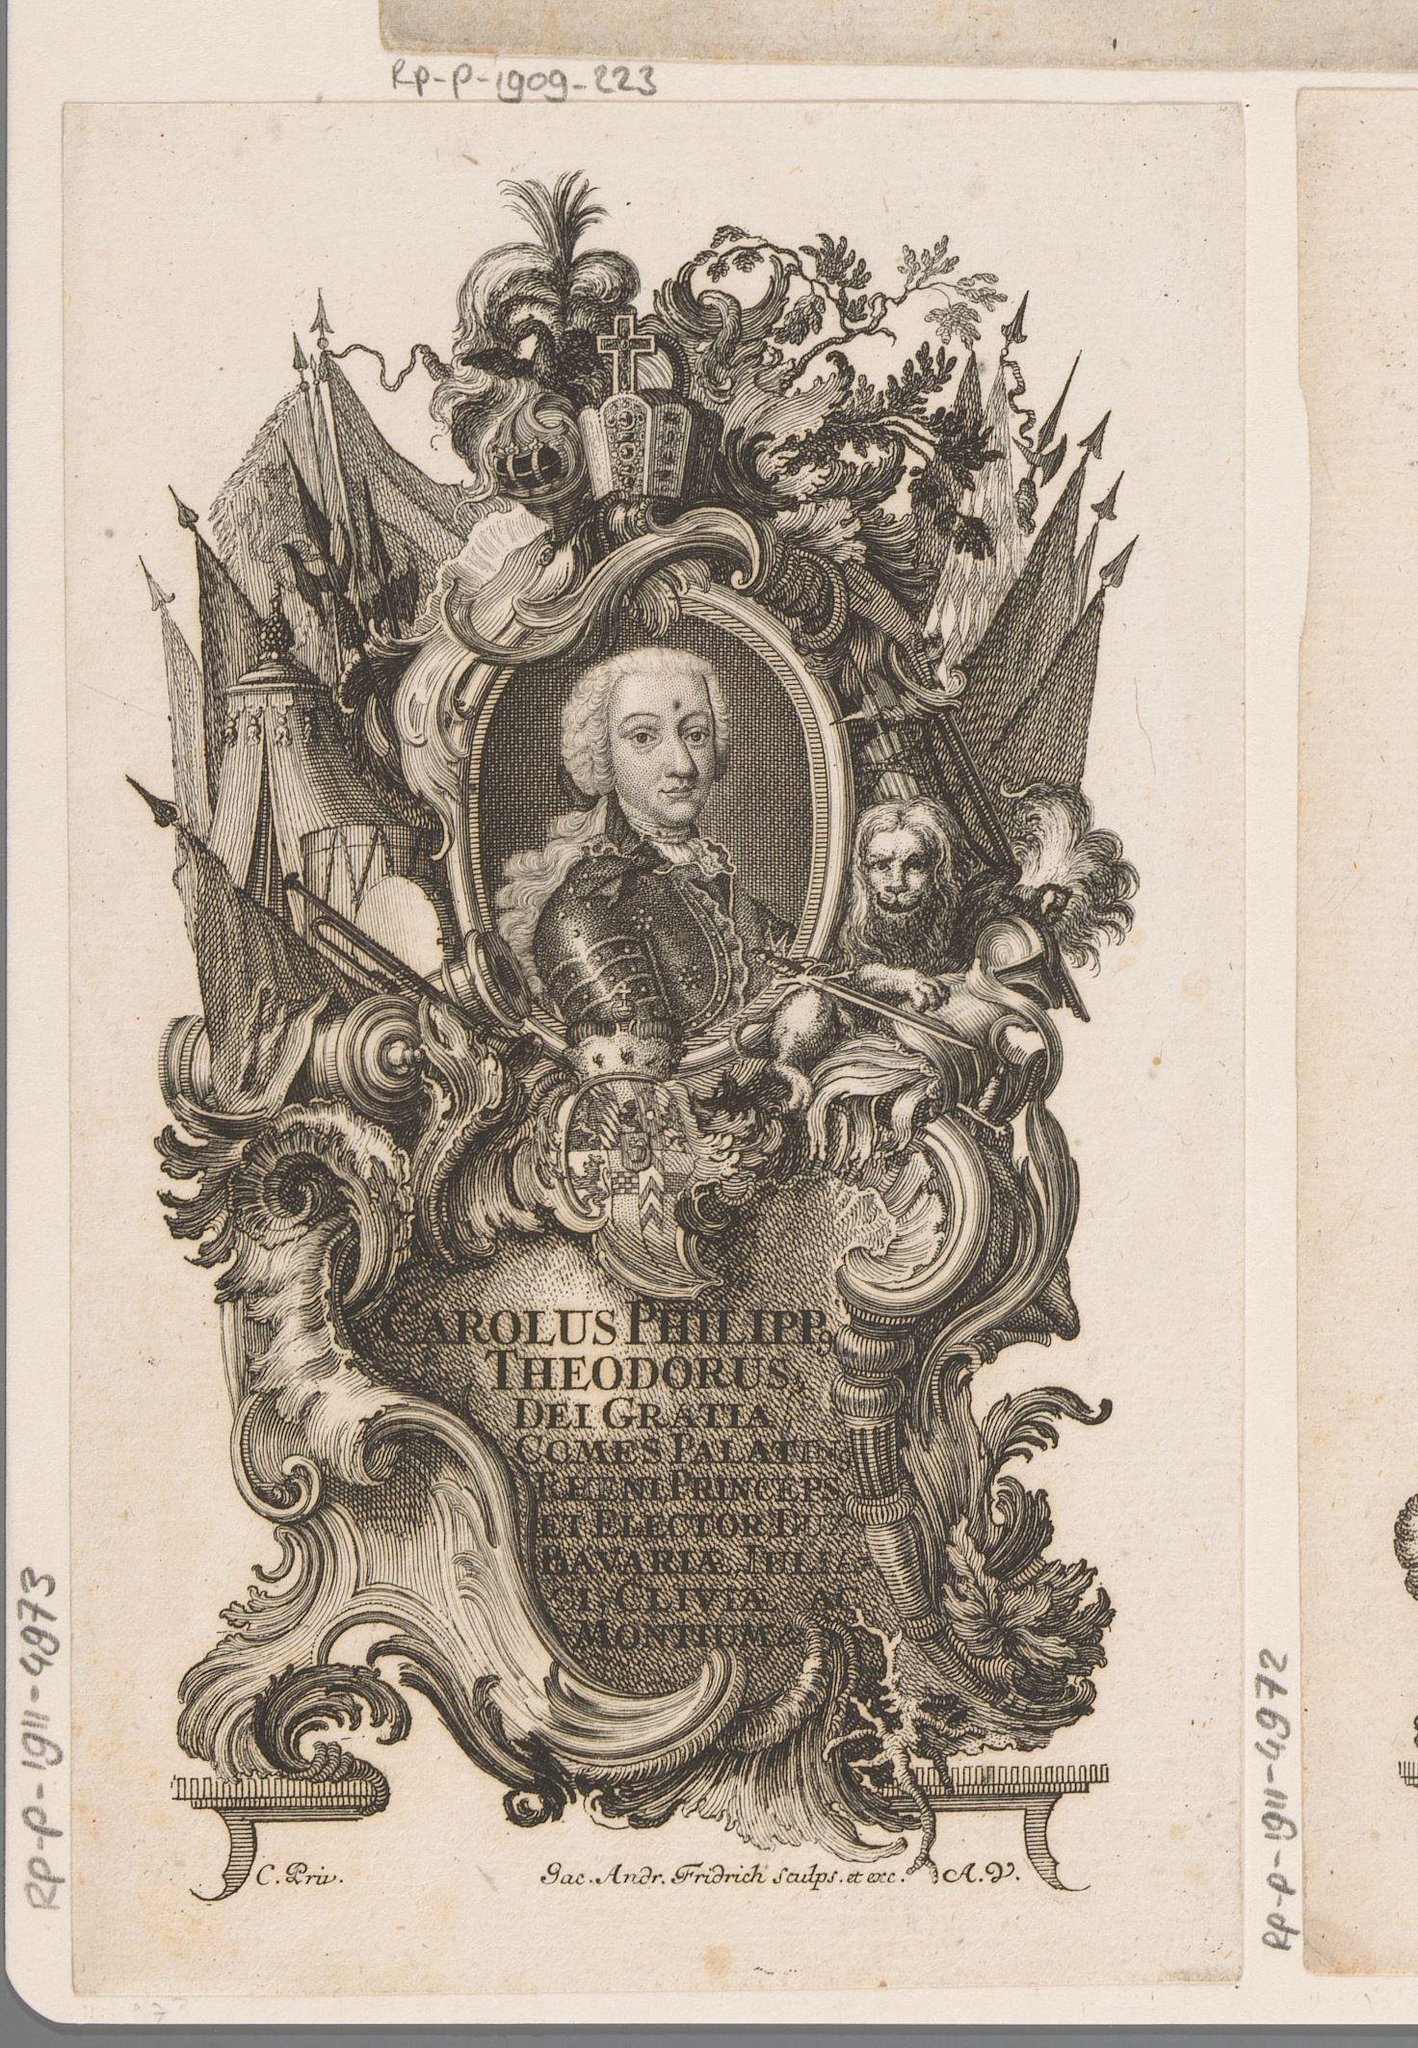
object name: print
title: Portret van Karel Theodoor van Beieren in allegorische omlijsting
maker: Anonymous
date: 1734-1779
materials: paper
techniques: engraving, etching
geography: holy roman empire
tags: brussels, karel theodoor van beieren (hertog), rocaille ornament, armour, historical persons, ruler, sovereign, symbols, allegories of war; 'guerra' (ripa), insignia and symbols of sovereignty (crown, diadem, sceptre, orb, seal, standard, cloak, pectoral)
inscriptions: collector's mark: Lugt 2228